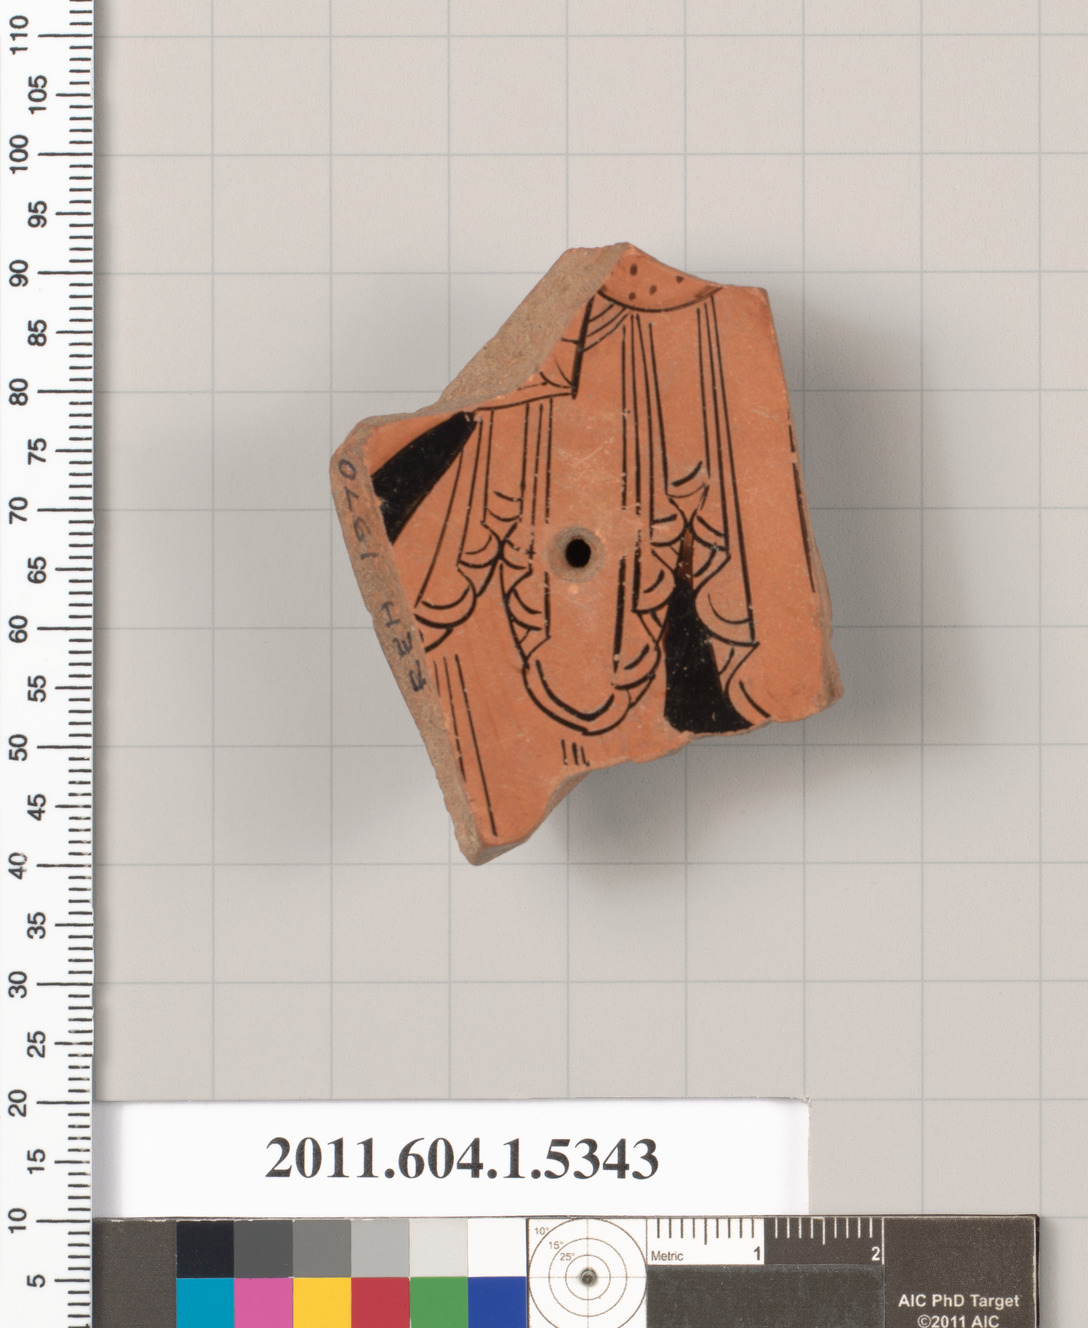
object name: kylix fragment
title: Terracotta fragment of a kylix (drinking cup)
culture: greek, attic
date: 500-480 BCE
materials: terracotta